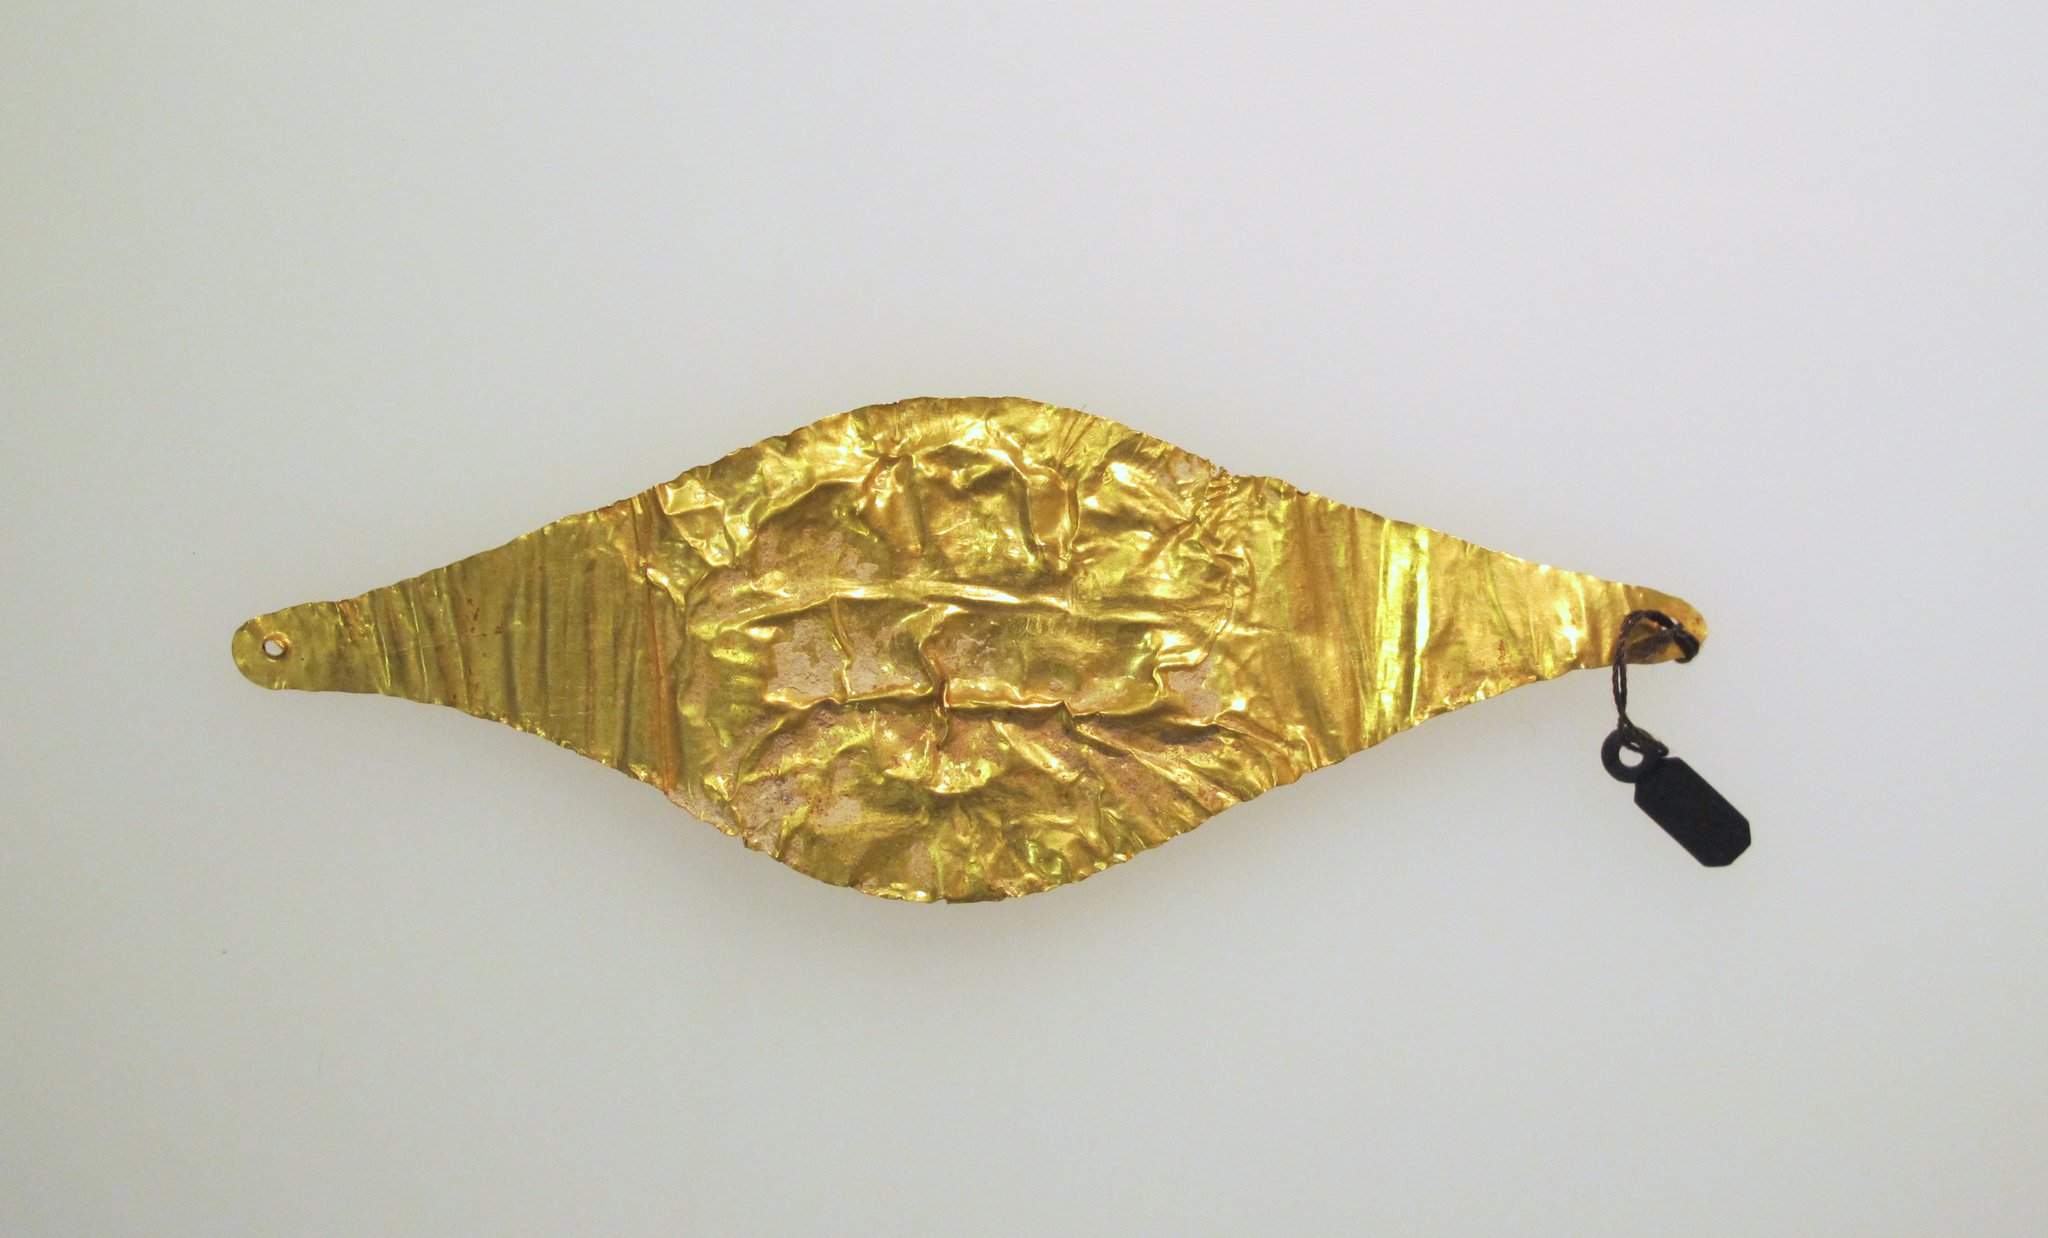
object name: mouth piece, funerary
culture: greek or roman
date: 7000 BCE-330 CE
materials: gold